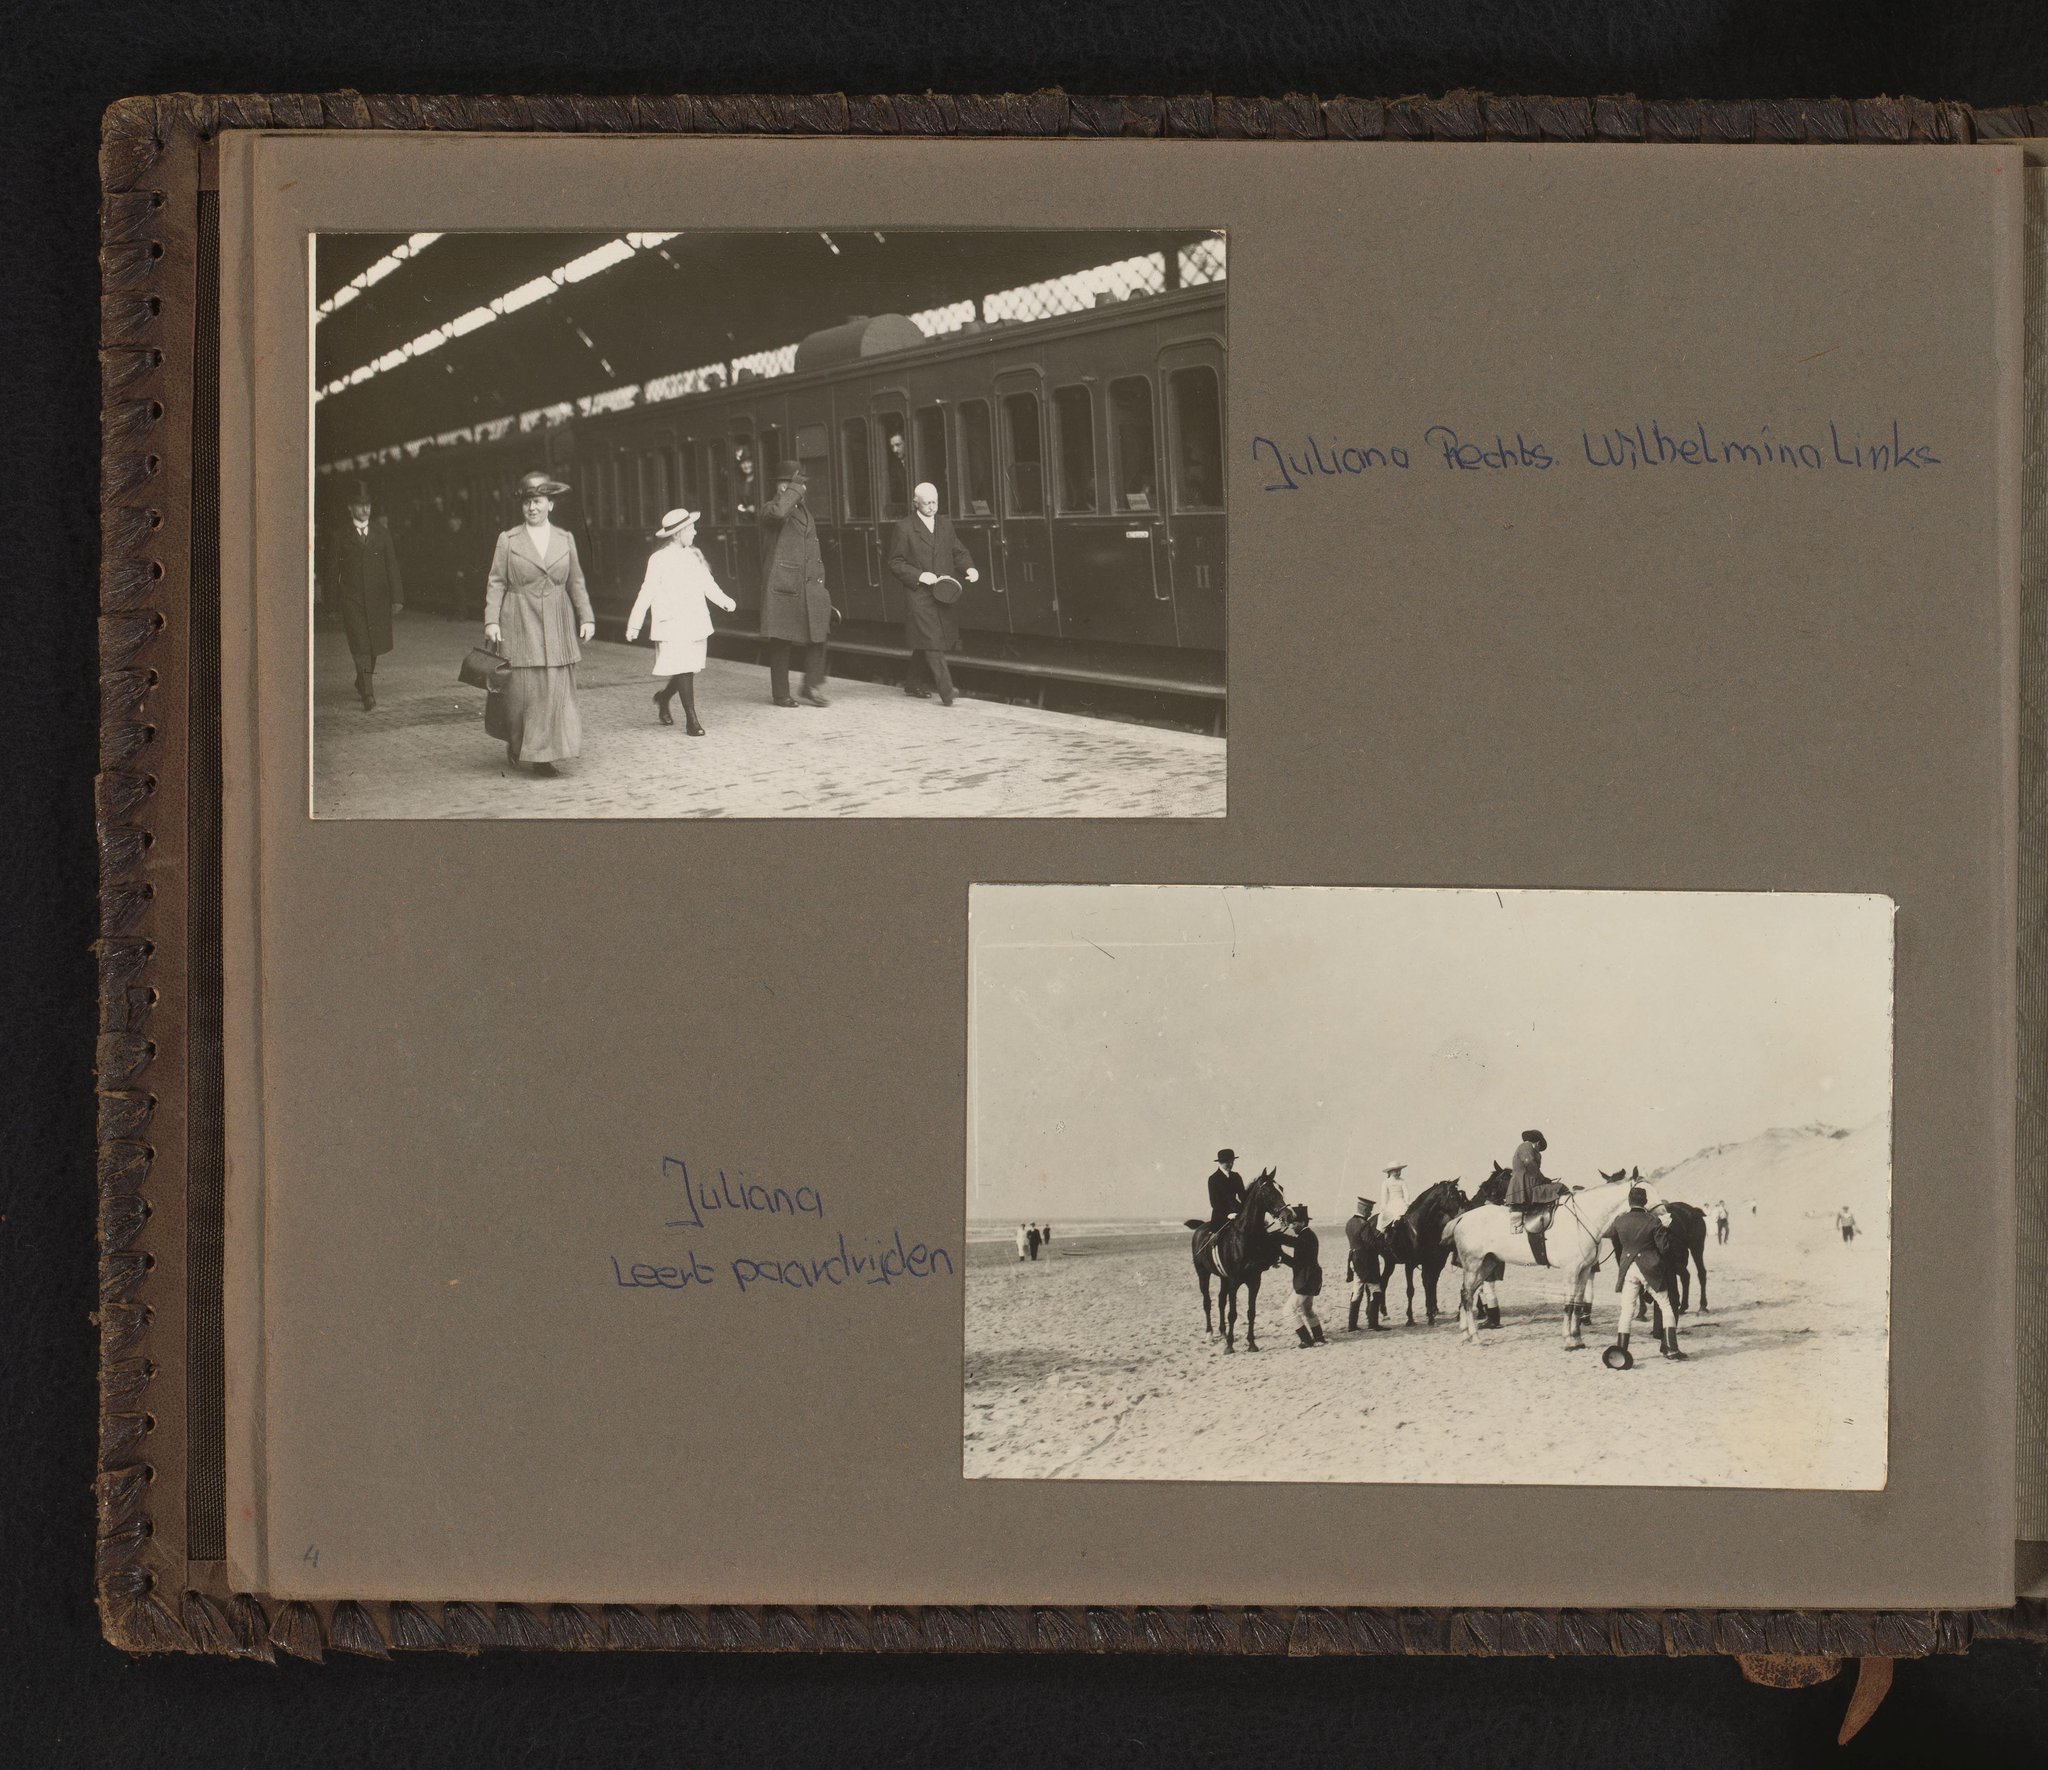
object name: photograph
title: Twee foto's van prinses Juliana als kind, op een station en bij paardrijles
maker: Anonymous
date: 1918-1924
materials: paper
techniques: gelatin silver print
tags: print maker, wilhelmina of the netherlands, the hague, juliana of the netherlands, riding a horse, ass, or mule; rider, horseman, platform (railway, tramway), girl (child between toddler and youth)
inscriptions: annotation: ‘Juliana rechts, Wilhelmina links’, annotation: ‘Juliana/ leert paardrijden’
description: Deze foto's maken deel uit van een album.